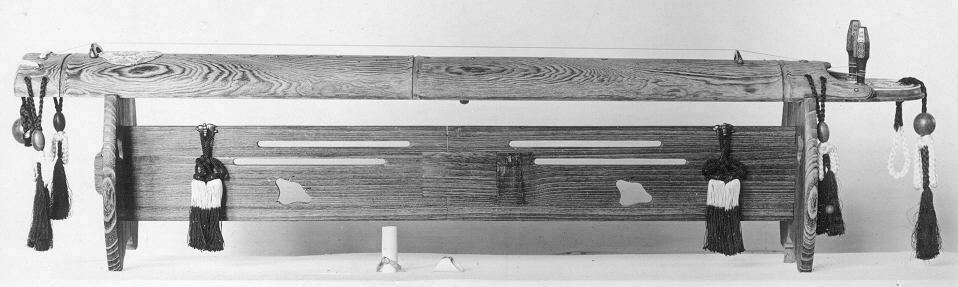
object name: nigenkin 二弦 琴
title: Nigenkin ( 二弦 琴 )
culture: japanese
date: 1801-1900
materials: textile, metal, silk, wood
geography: japan